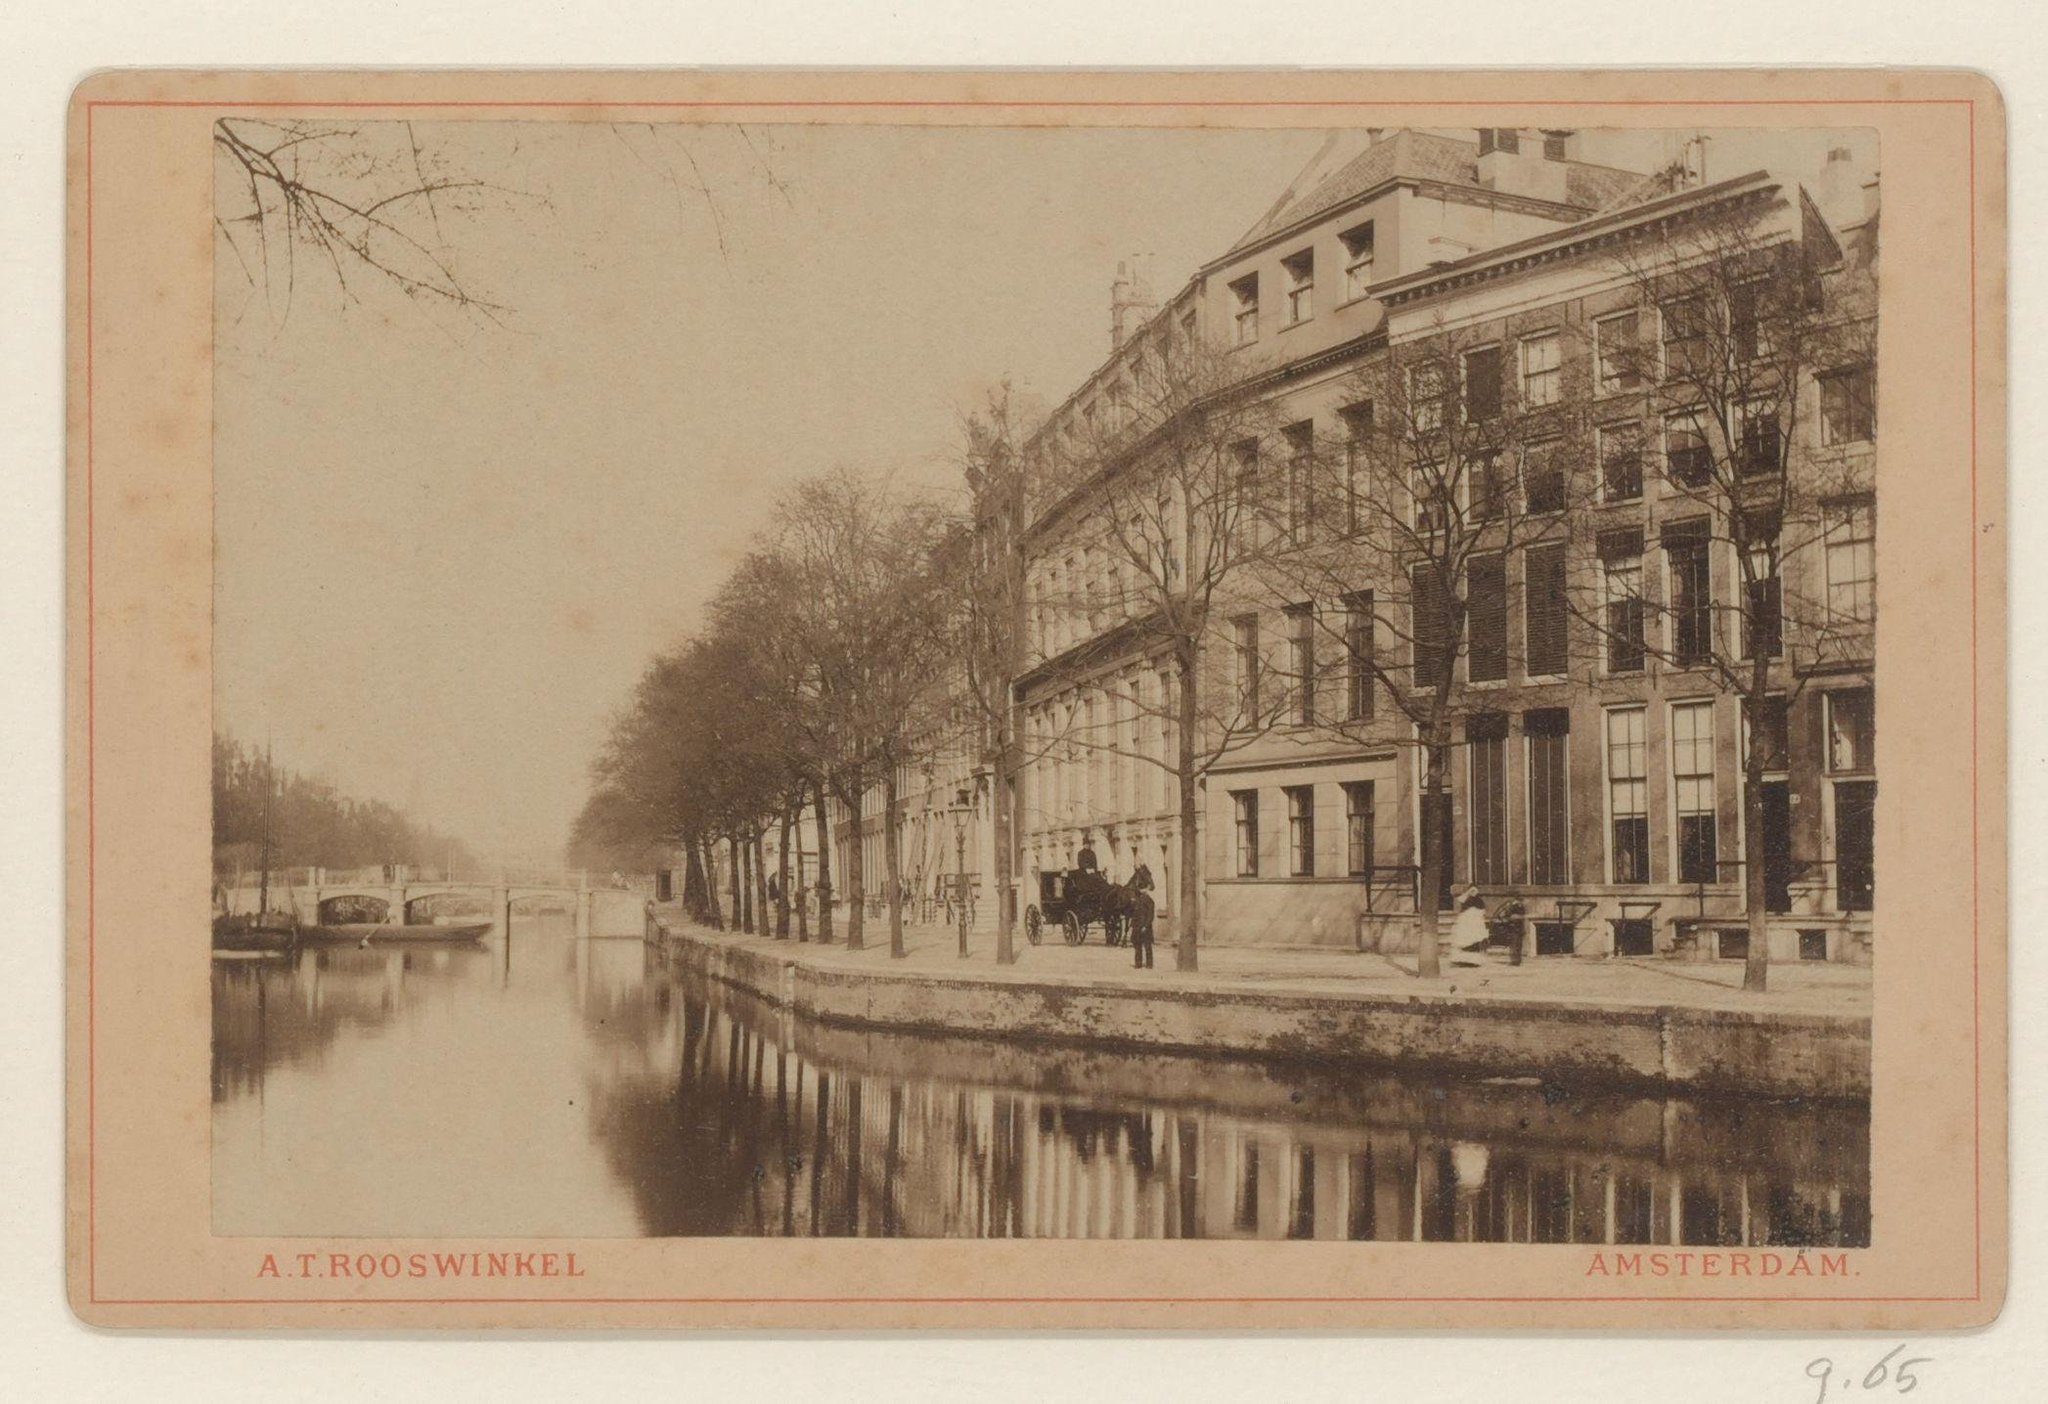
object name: carte de visite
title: Gezicht op de Hogere Burgerschool aan de Keizersgracht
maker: andreas theodorus rooswinkel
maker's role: fotograaf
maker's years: 1838-1909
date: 1875-1896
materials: cardboard, paper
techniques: albumen print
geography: amsterdam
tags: city-view in general; 'veduta', canal, the usual house or row of houses, street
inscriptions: stamp: ‘Gebr. Douwes / Atelier / Grimburgwal 15 / Amsterdam’, collector's mark: ‘9.65’ Lugt 1641b, inscription: ‘69 / Hoogere Burgerschool met / 5 ongen m[...] keizersgracht’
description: Onderwerpsrubriek binnen de Atlas Amsterdam: Kadijksplein, Karthuizerkerkhof, Kattegat, Kattenburg, Kapelsteeg O.Z., Enge Kerksteeg, Kerkstraat, Kinkerstraat, Kolk O.Z., Koningsplein, Kromboomsloot [Krom Boomssloot], Kostverlorenkade, Kwakersdwarspad, Kalverstraat, Keizersgracht (v.d. Brouwersgracht – Amstel), Klerensloot (Gedempte), Klimopstraat, Kloveniersburgwal, Kraansluis.